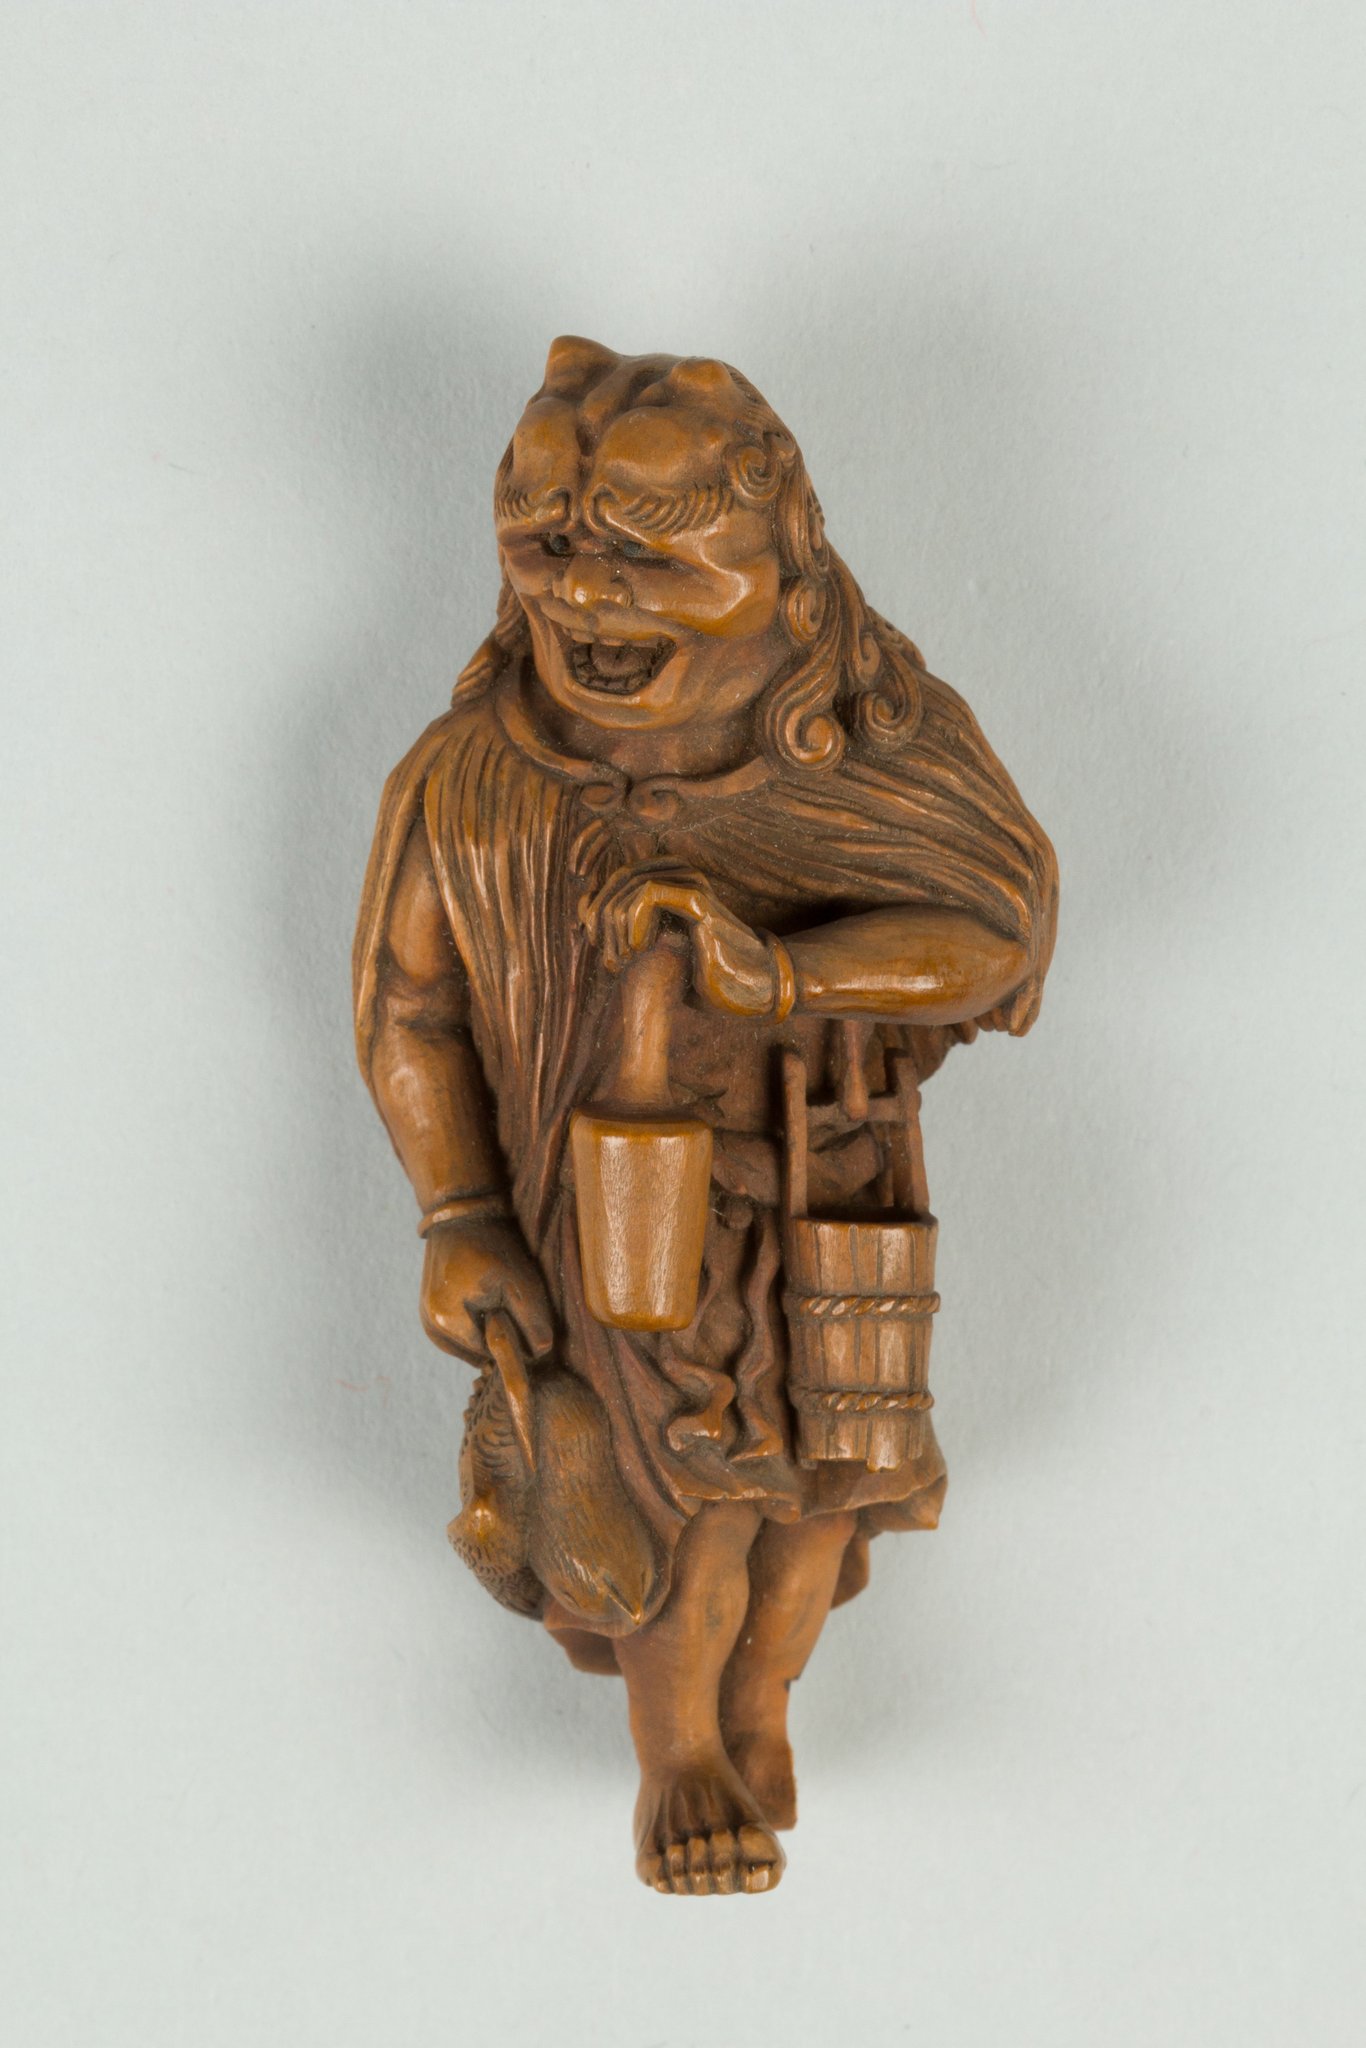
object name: netsuke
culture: japanese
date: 1801-1900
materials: wood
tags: human figures